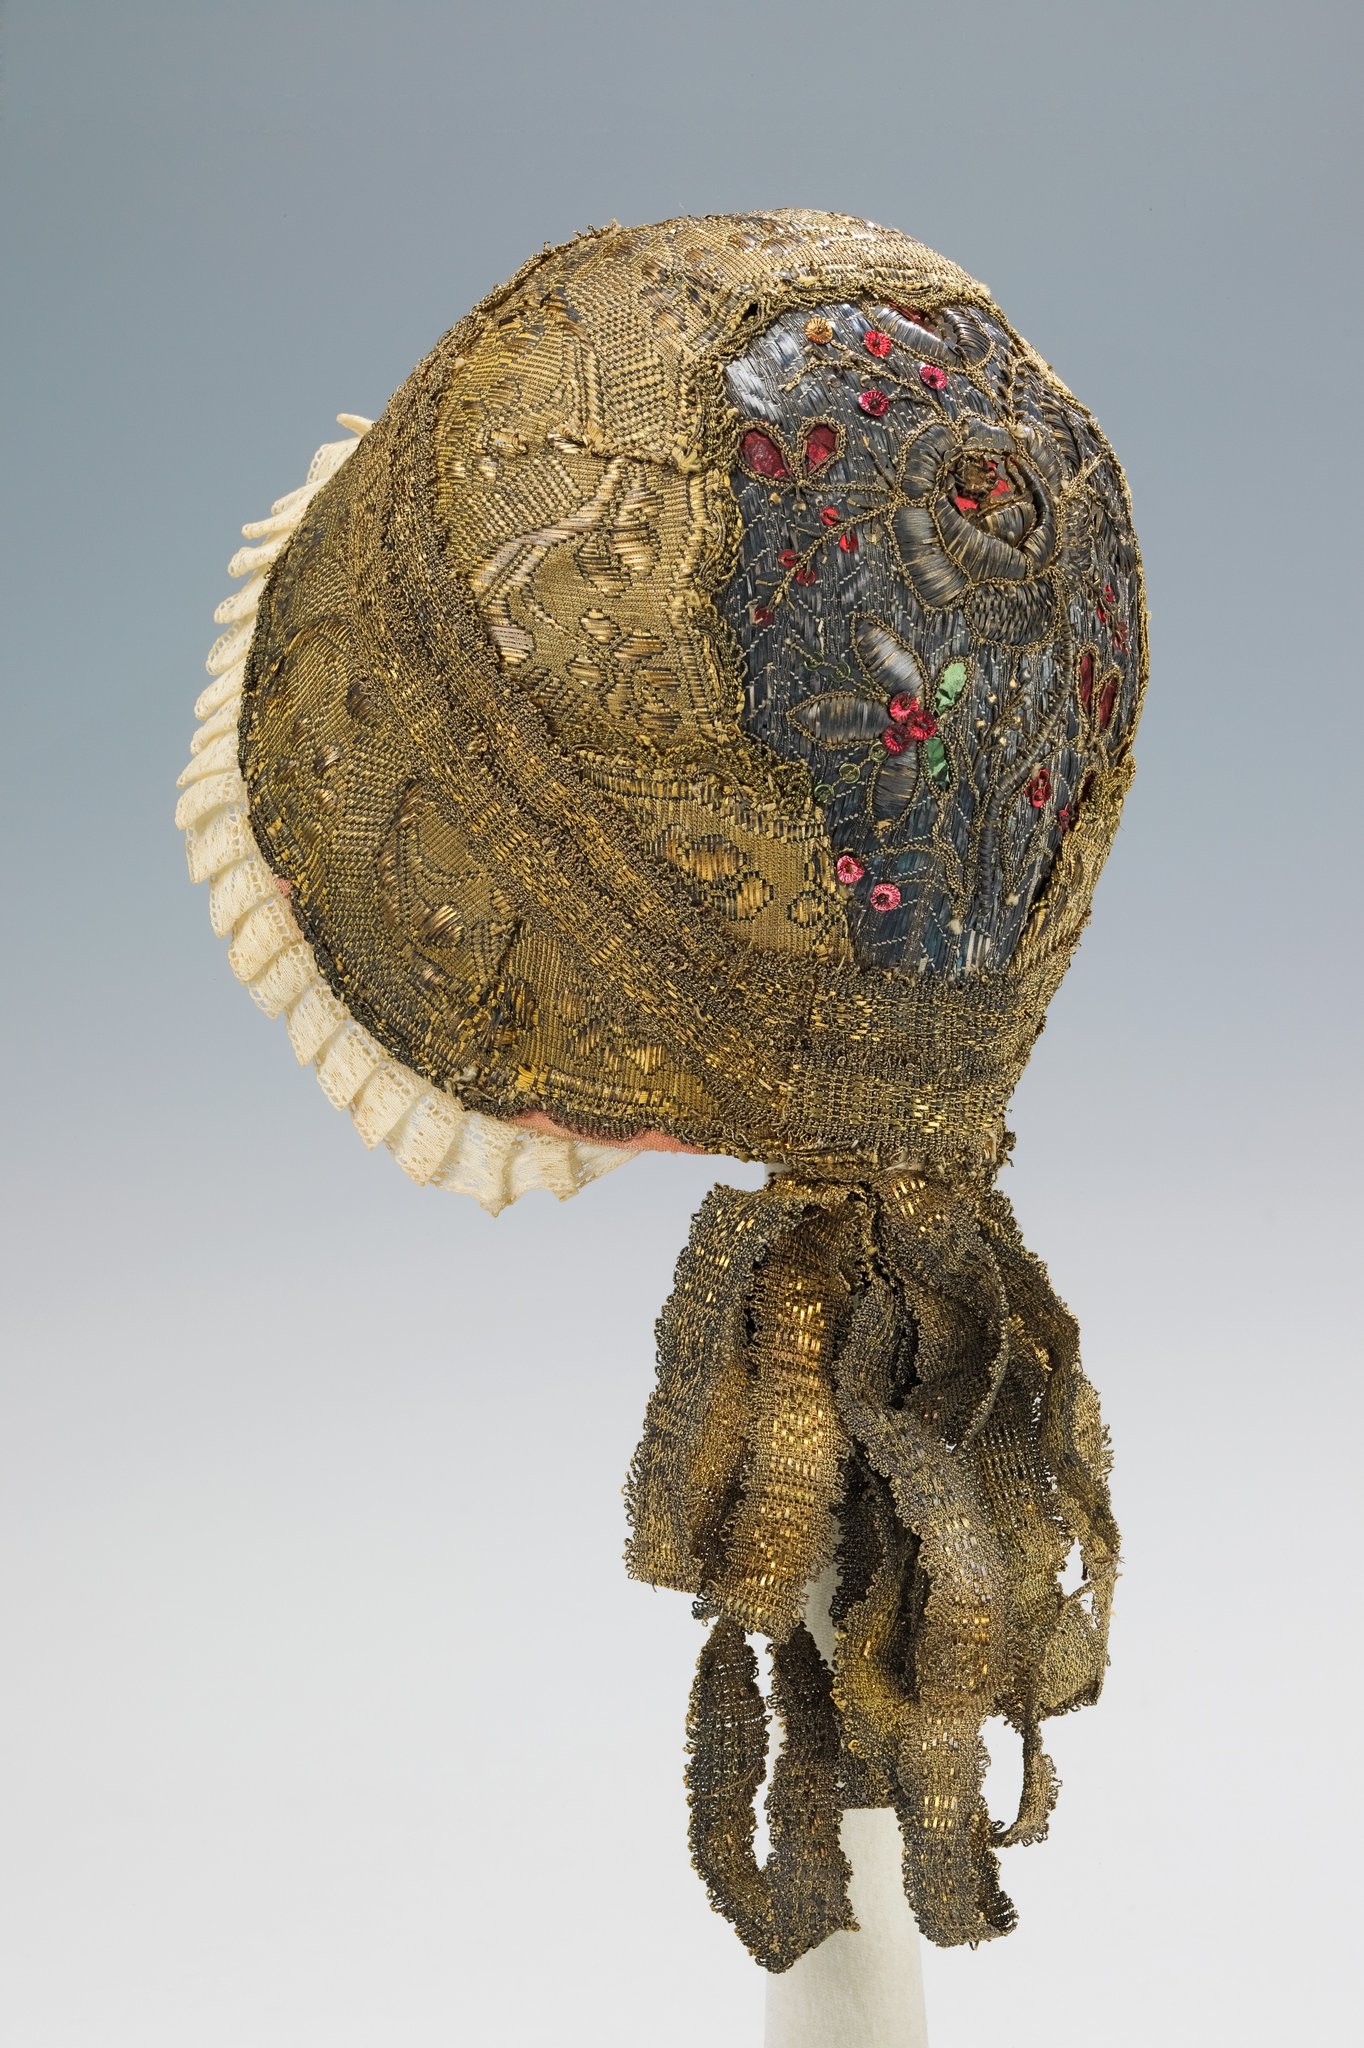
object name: cap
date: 1801-1833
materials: linen, metal, paper